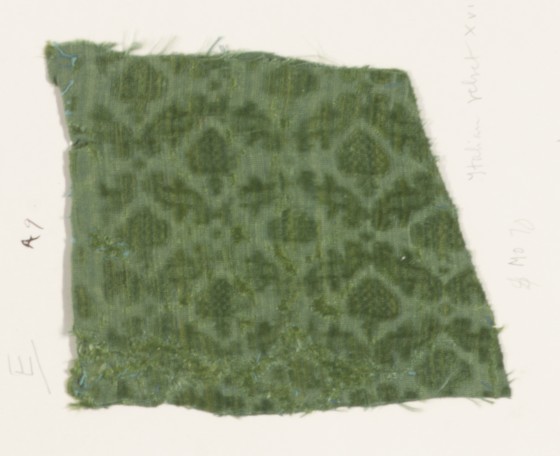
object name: fragment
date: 1501-1700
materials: silk